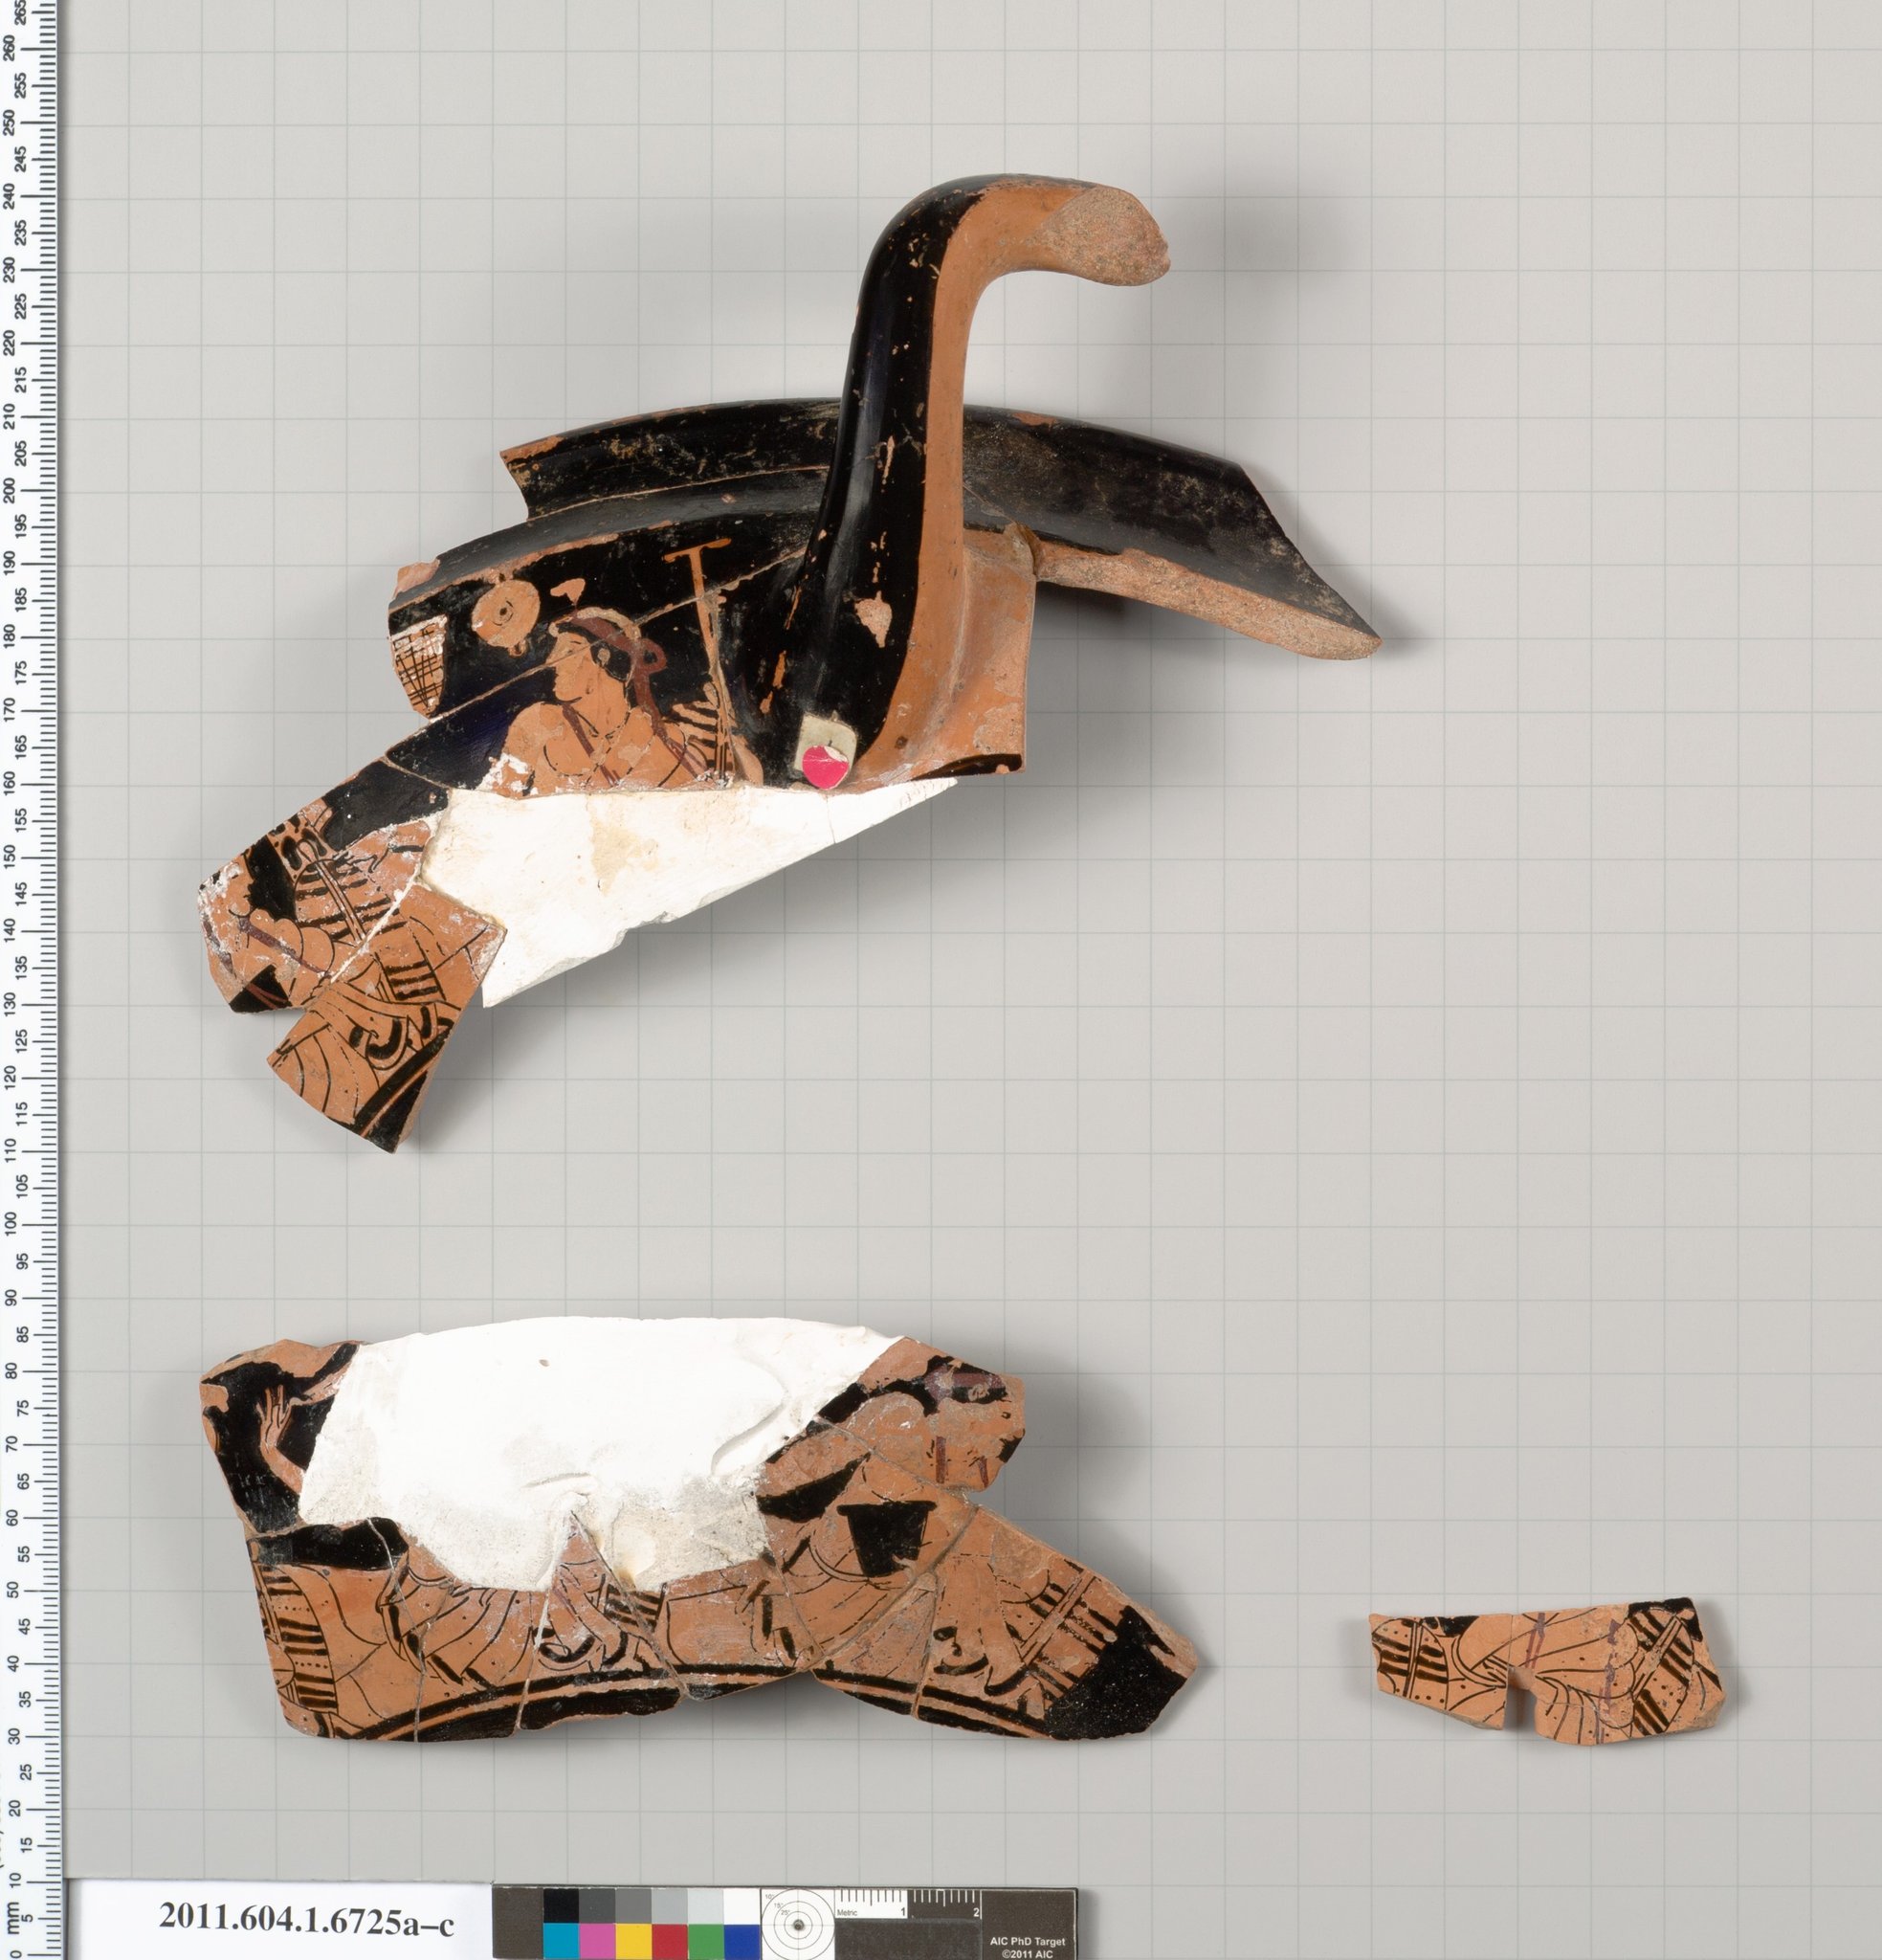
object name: kylix fragment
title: Terracotta fragments of a kylix (drinking cup)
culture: greek, attic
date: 490-470 BCE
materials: terracotta